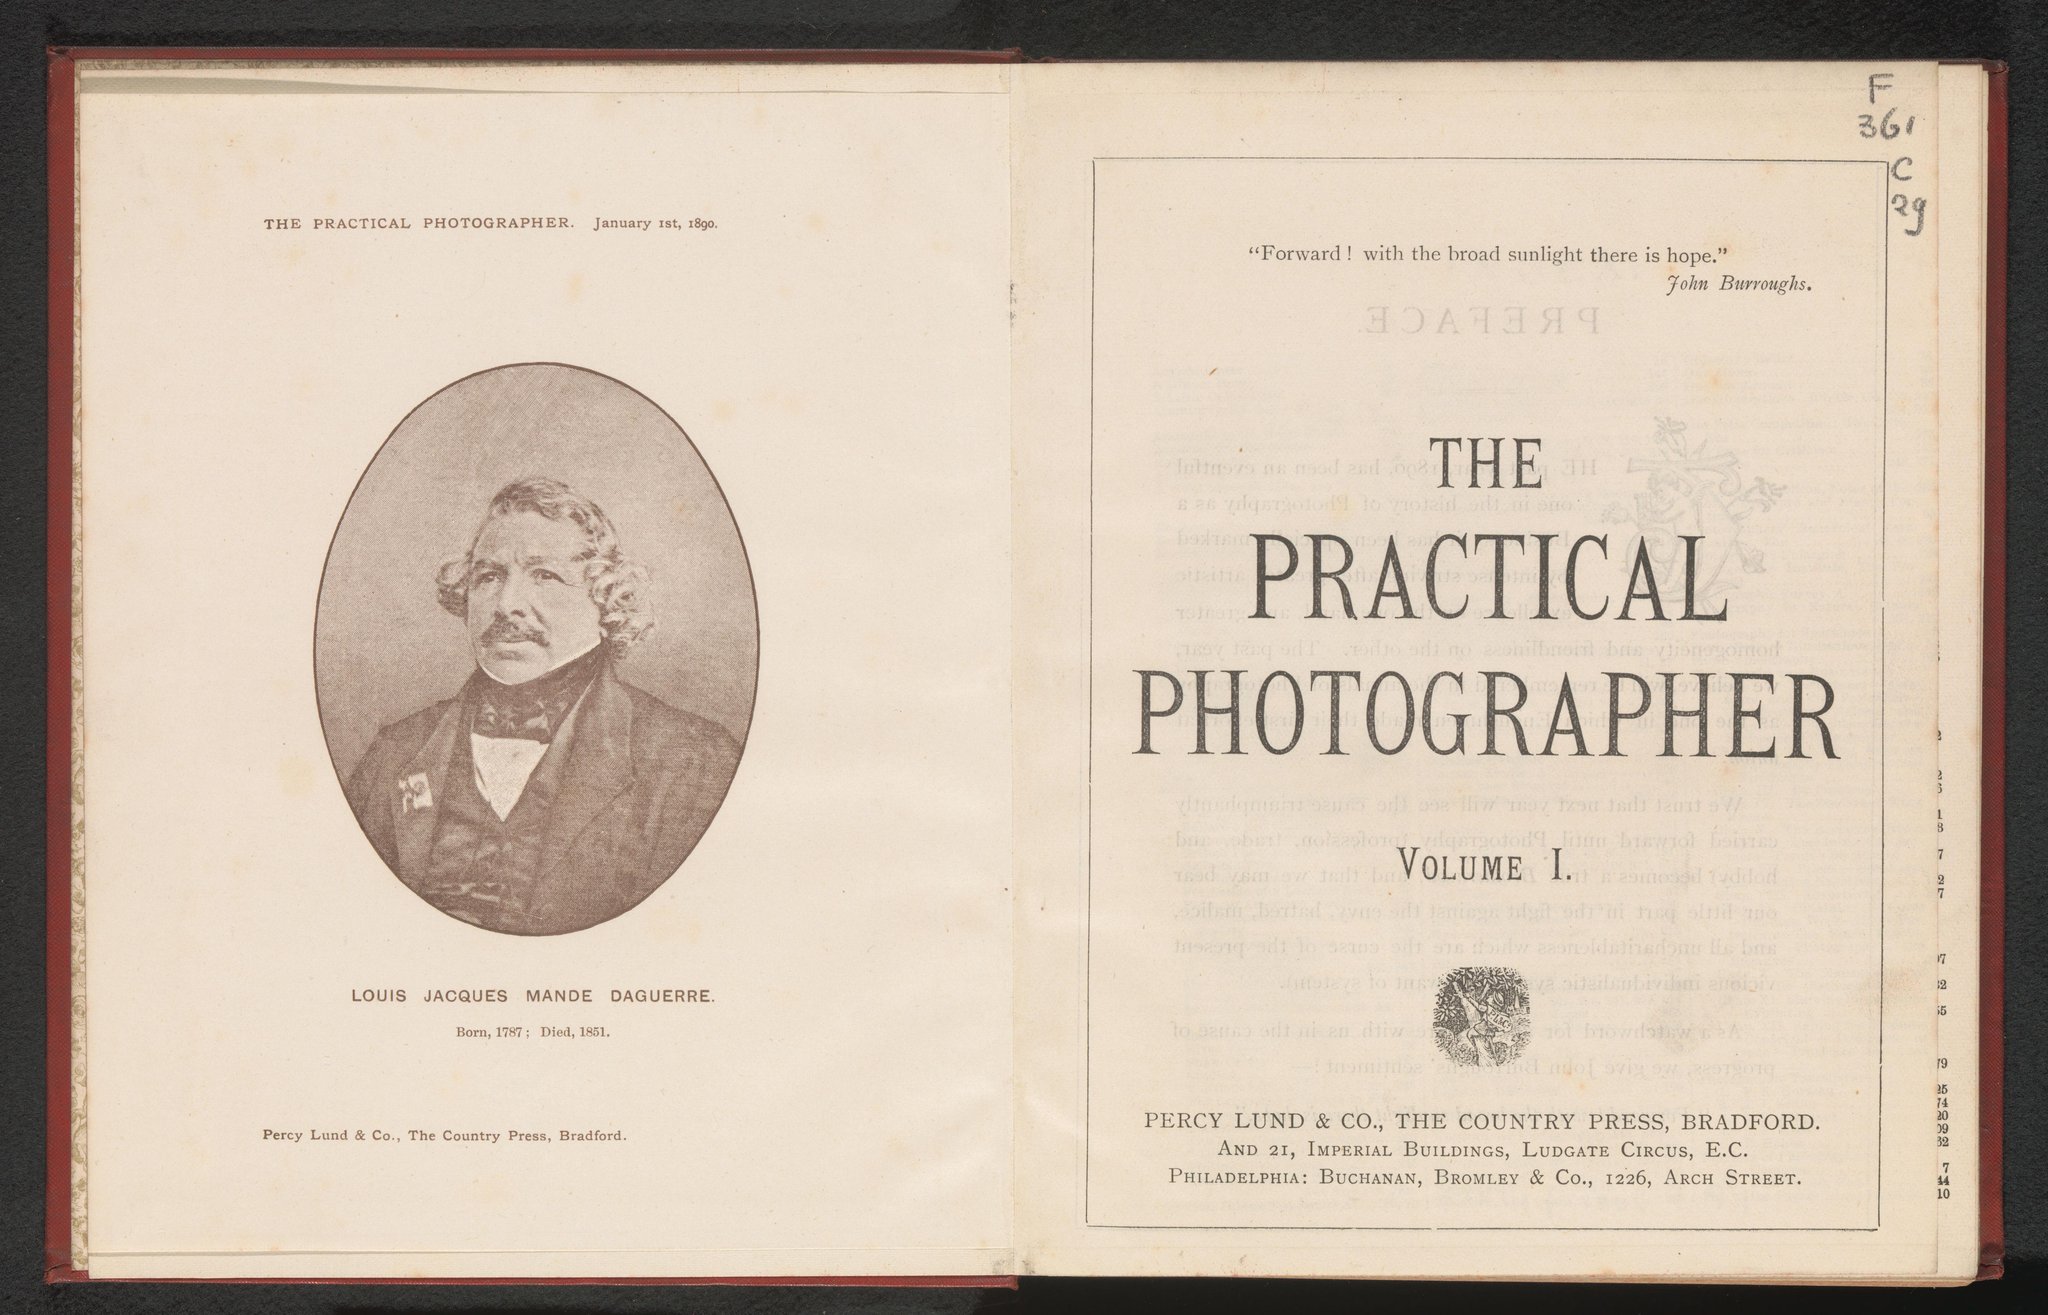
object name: book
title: The practical photographer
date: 1890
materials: cardboard, linen, paper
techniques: printing, engraving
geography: philadelphia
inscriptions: date: ‘AUG/ 1998’